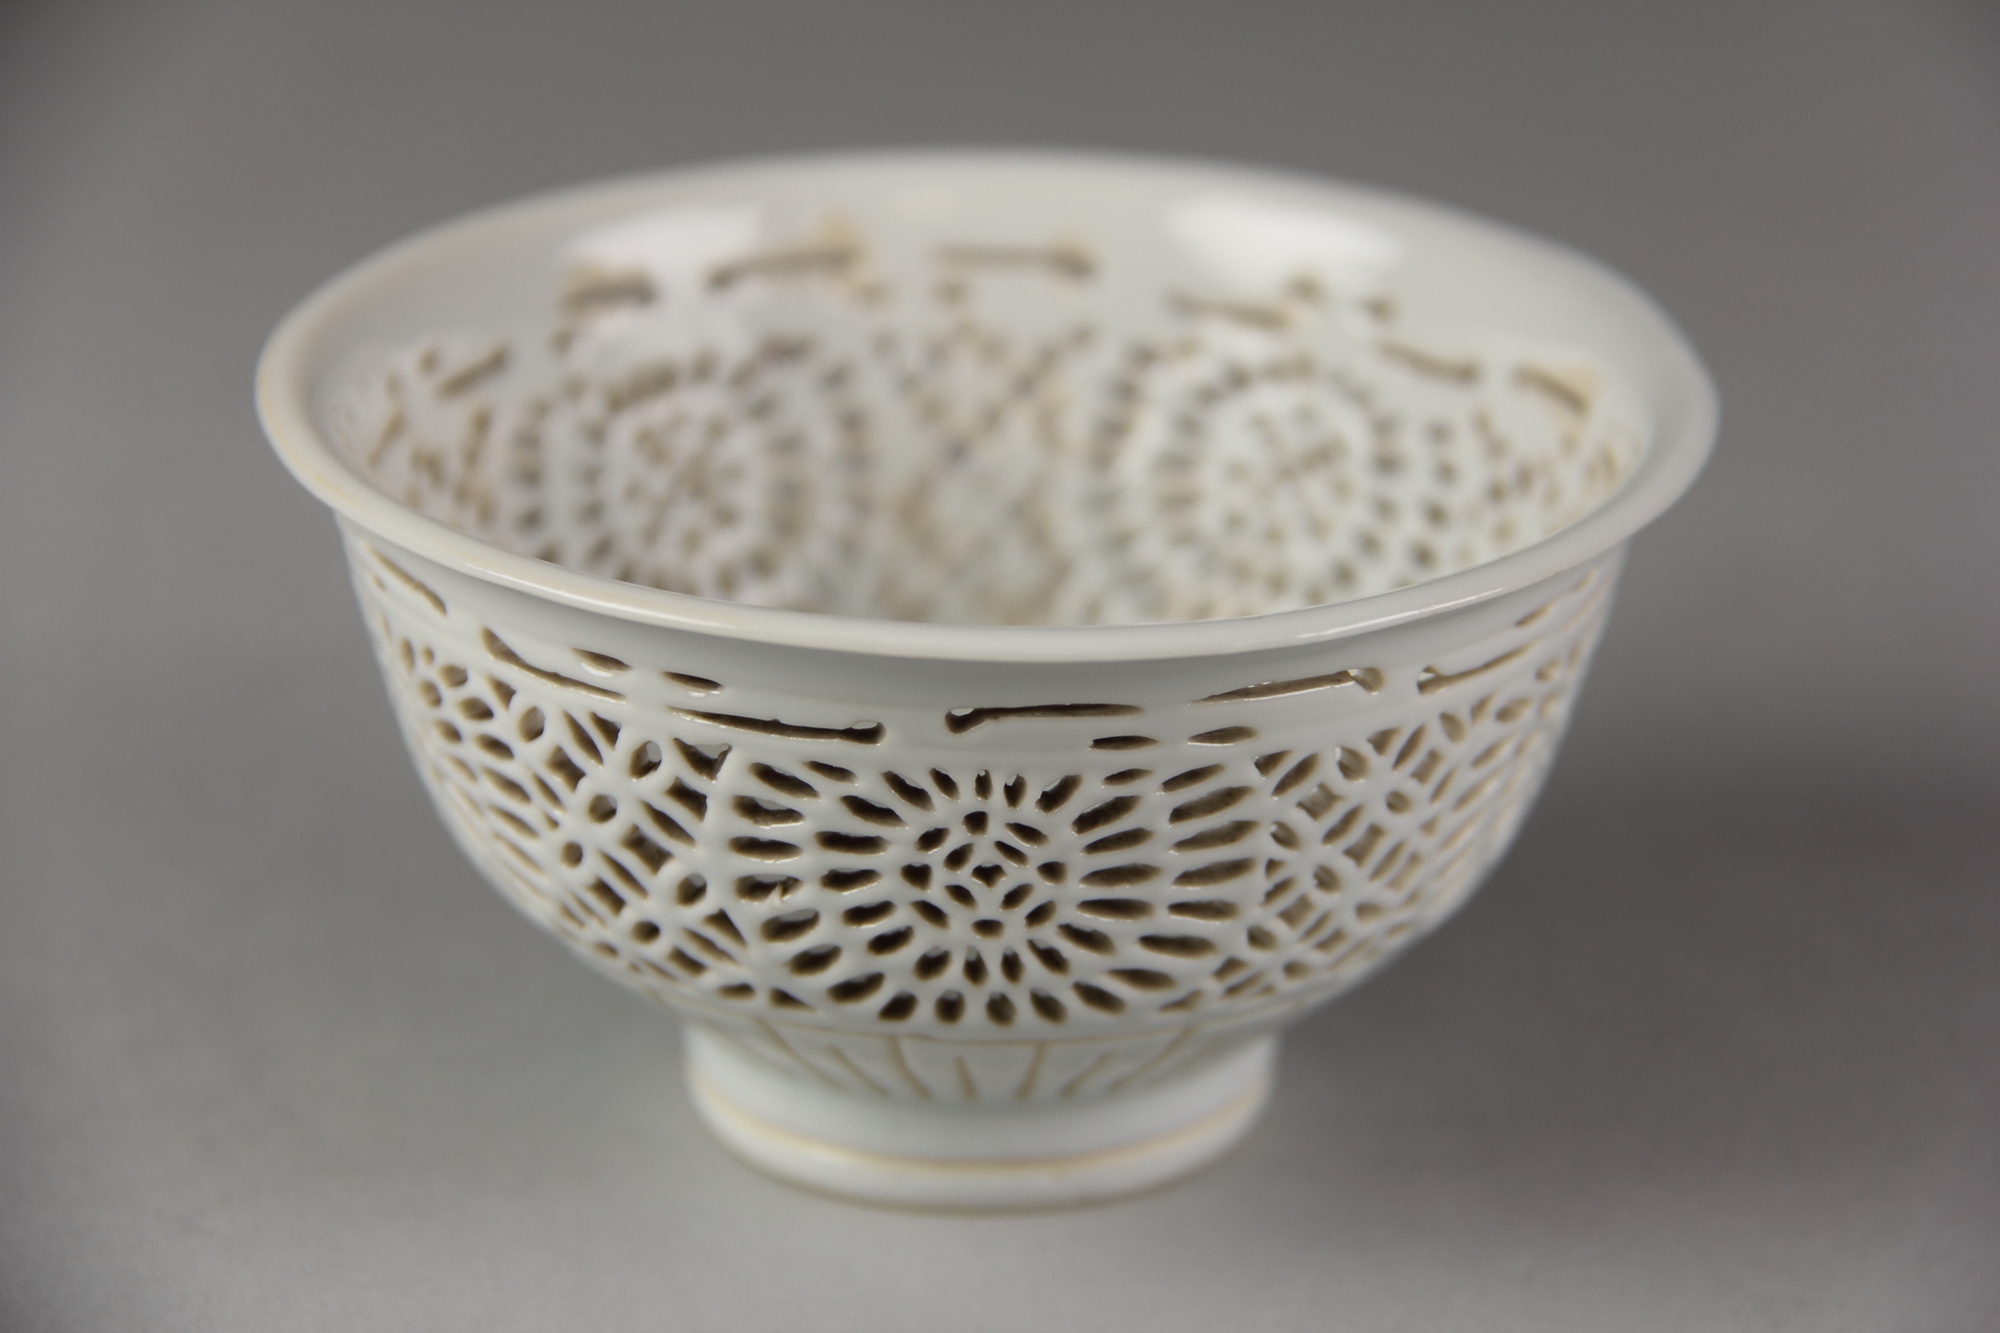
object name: bowl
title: Bowl with floral pattern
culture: chinese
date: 1701-1800